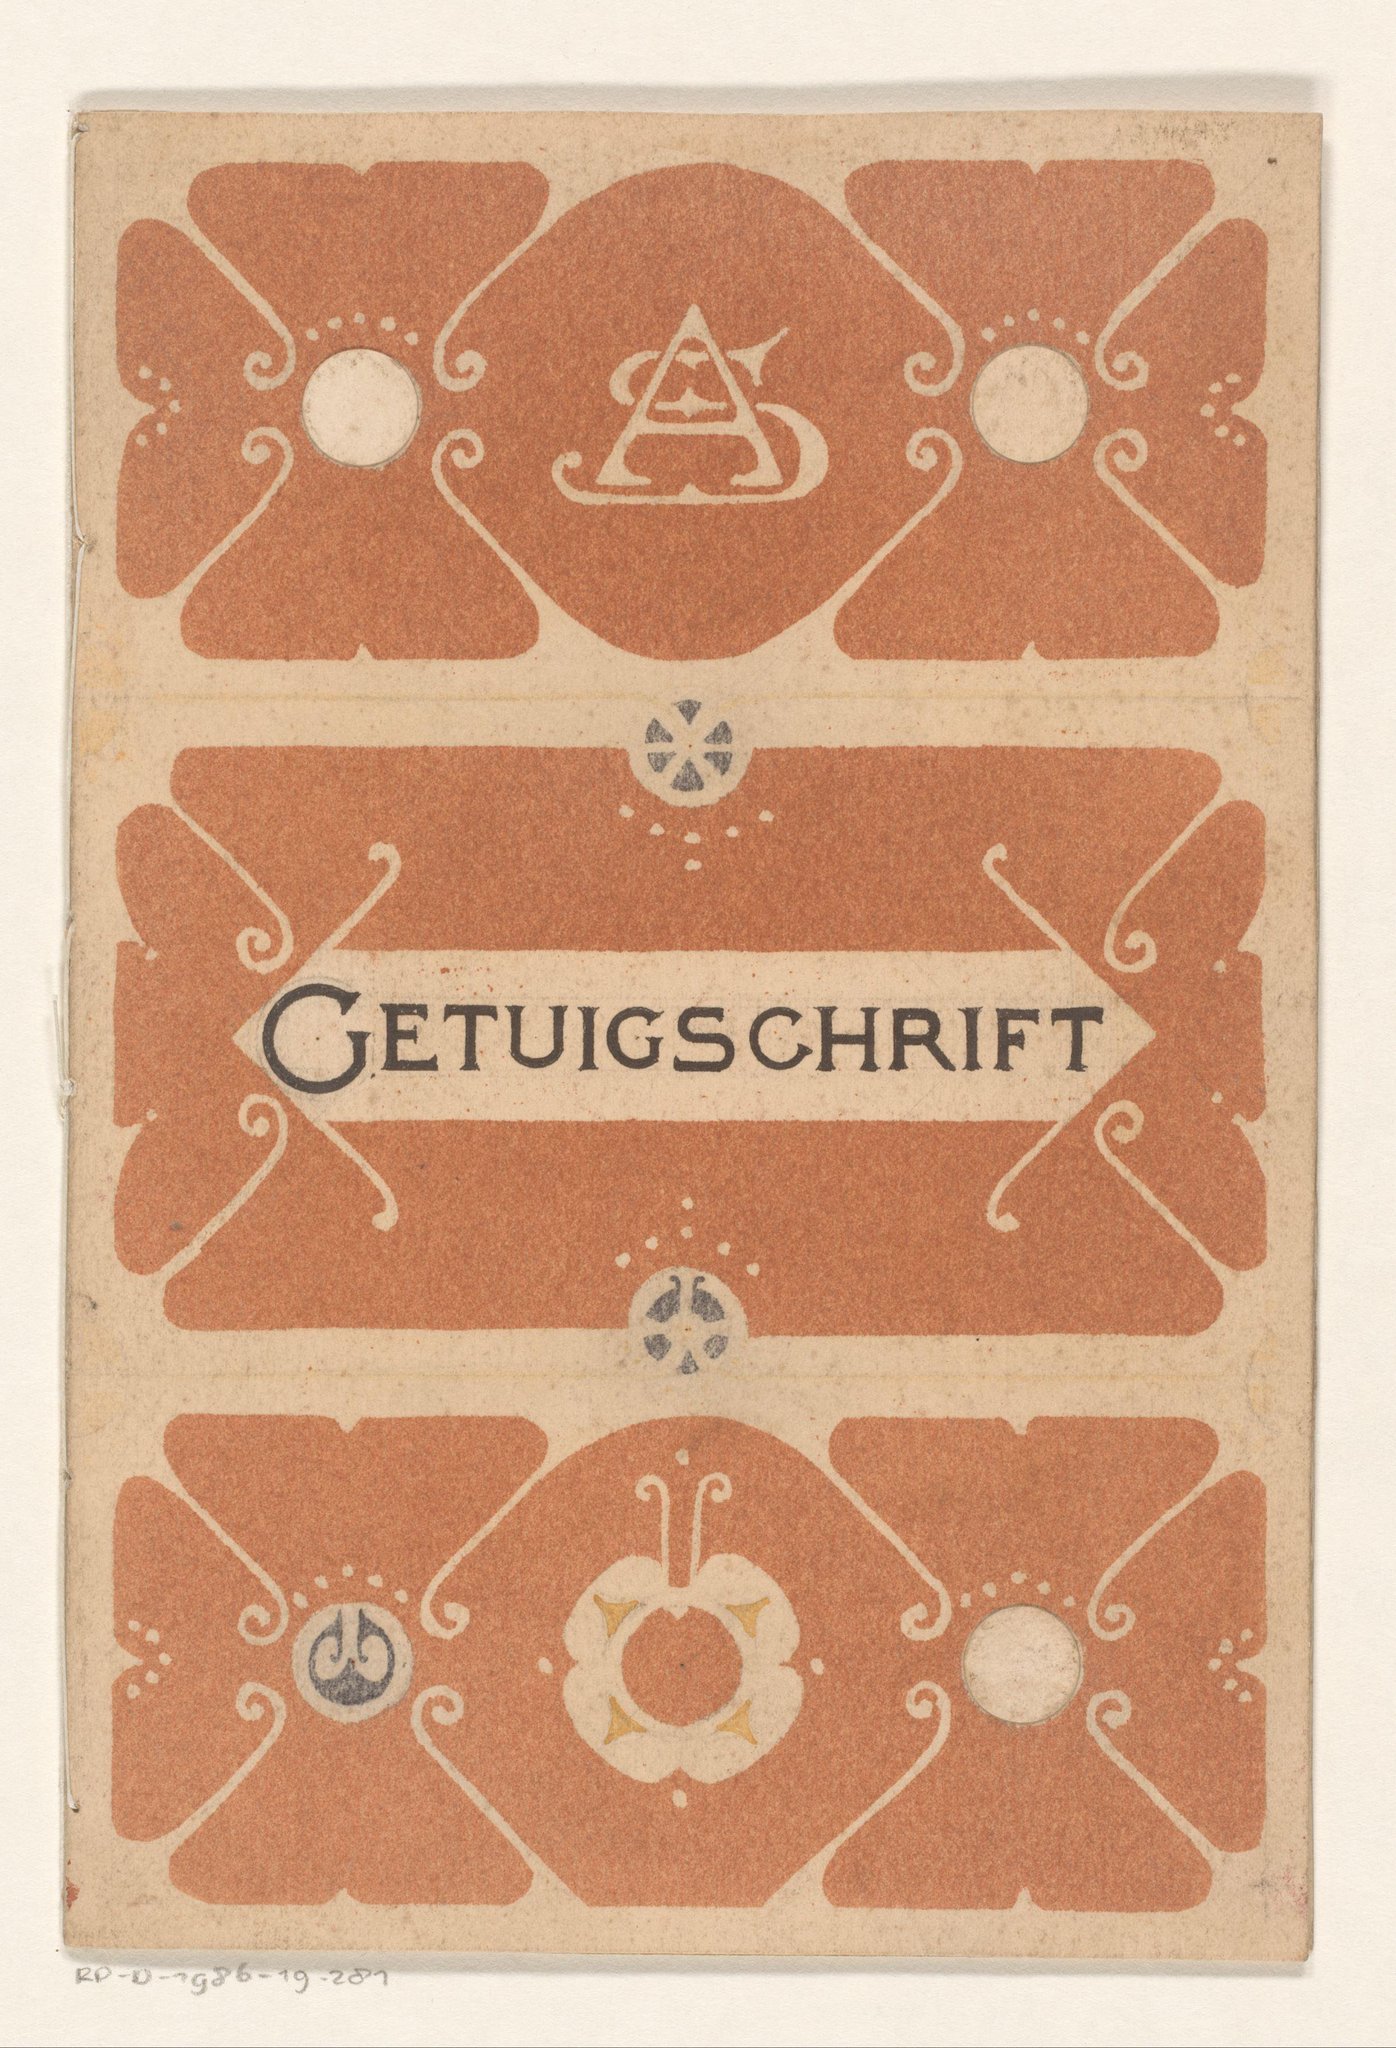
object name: testimonial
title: Ontwerp voor een getuigschrift van de Ambachtsschool te Amsterdam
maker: reinier willem petrus de vries (1874-1953)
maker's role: draughtsman, print maker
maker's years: 1874-1953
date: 1903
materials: ink, paper, pencil, watercolor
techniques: brush, lithograph, pen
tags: ornaments ~ art, magic mathematical figures; magic numbers, words, monograms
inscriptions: annotation: ‘motto: "Ambachtsschool"’, number: ‘20’, collector's mark: ‘R:MVS.’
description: Ingebonden ontwerp voor een getuigschrift van Johan Willem van der Heijden van de Ambachtsschool te Amsterdam bestaande uit drie prenten: een titelblad, getuigschrift en cijferlijst. Op de omslag een versierde letter 'A' en een vignet bestaande uit verschillende gereedschappen.